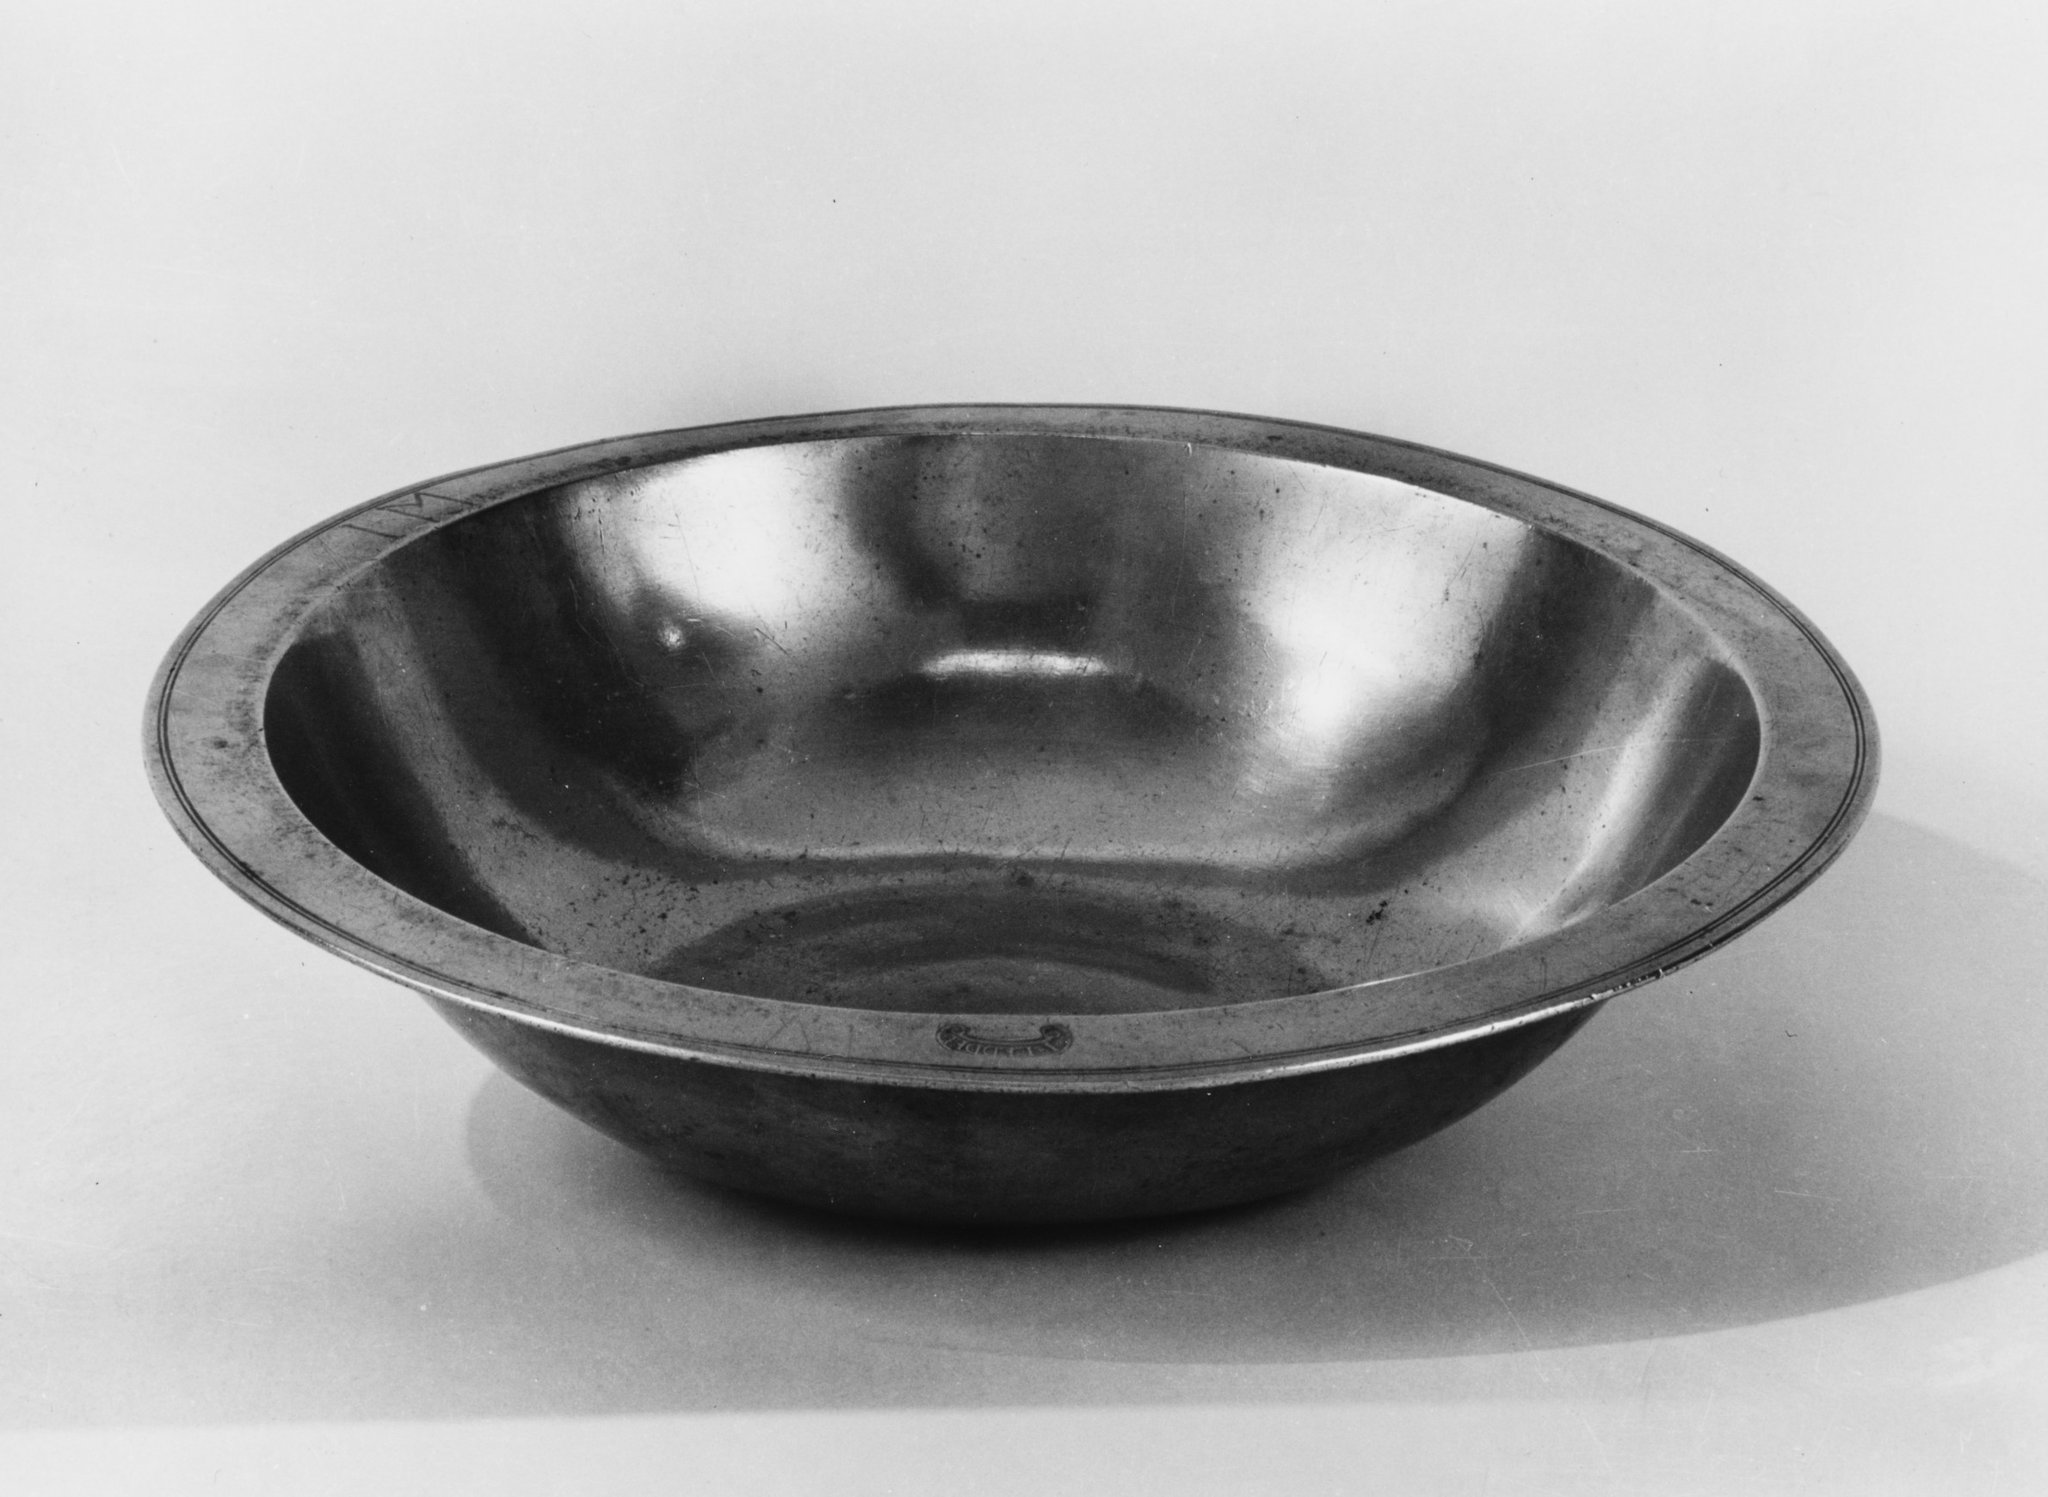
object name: basin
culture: american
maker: joseph leddel sr.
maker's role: maker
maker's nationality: american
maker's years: 1690-1754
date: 1712-1754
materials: pewter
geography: united states